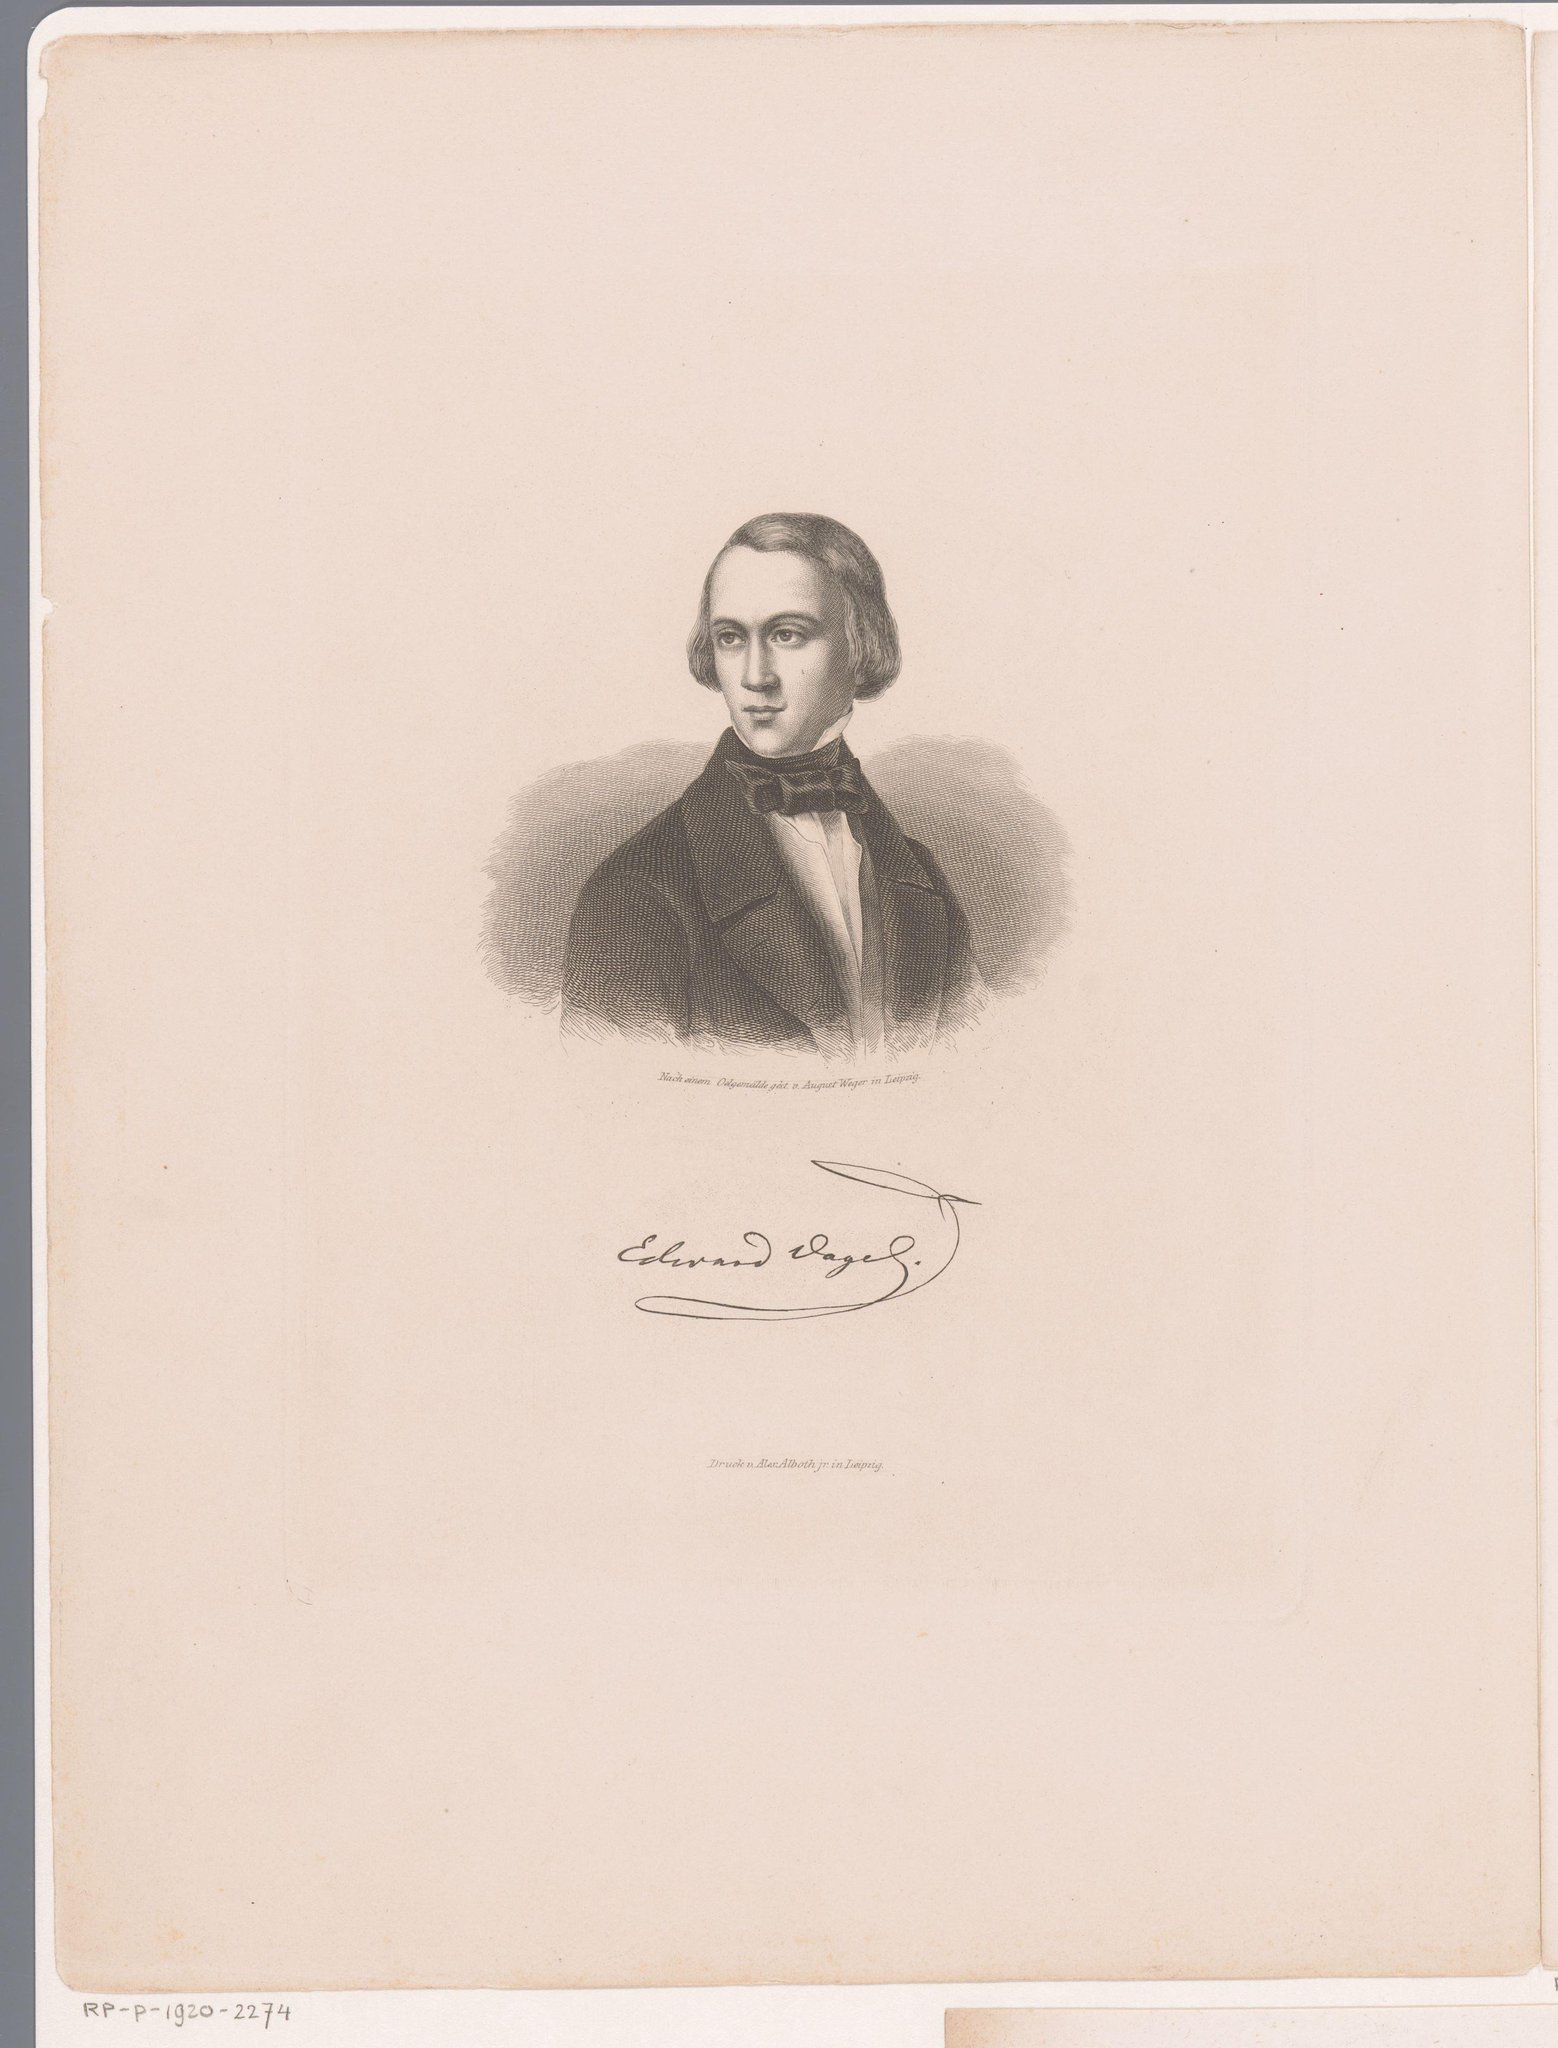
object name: print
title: Portret van Eduard Vogel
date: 1849-1892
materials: paper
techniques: engraving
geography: leipzig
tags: historical persons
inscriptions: collector's mark: Lugt 2228